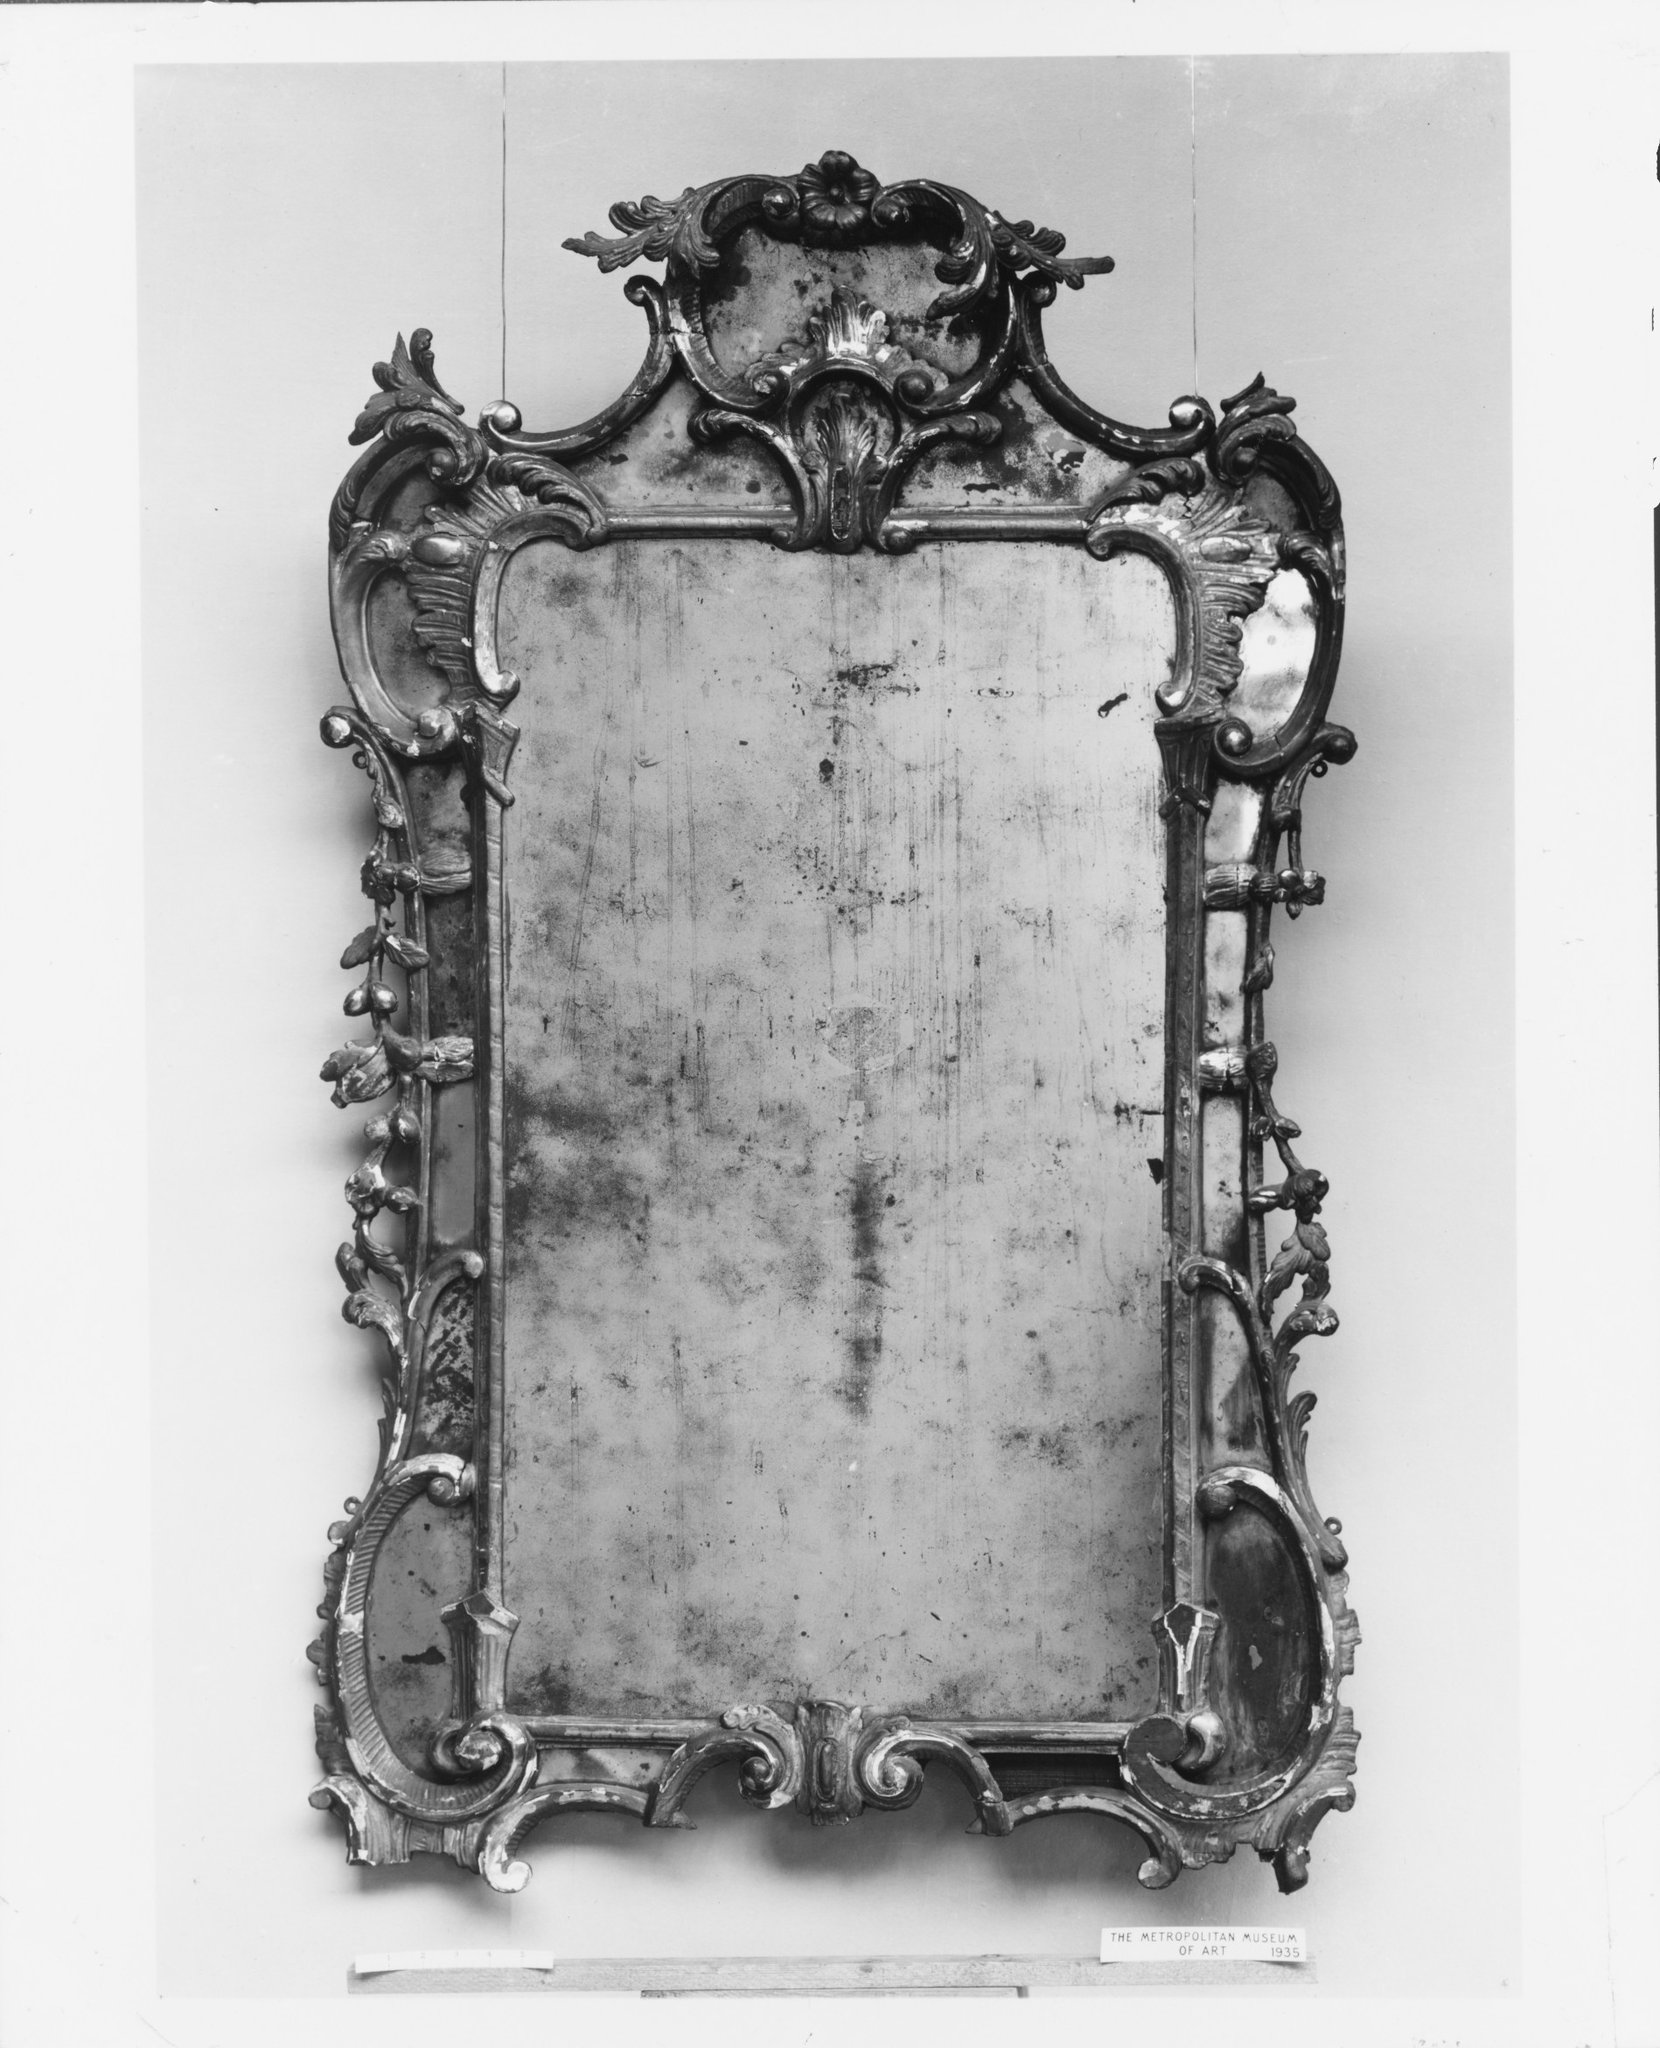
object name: looking glass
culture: american or british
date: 1745-1780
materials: gesso, wood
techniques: gilding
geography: united states